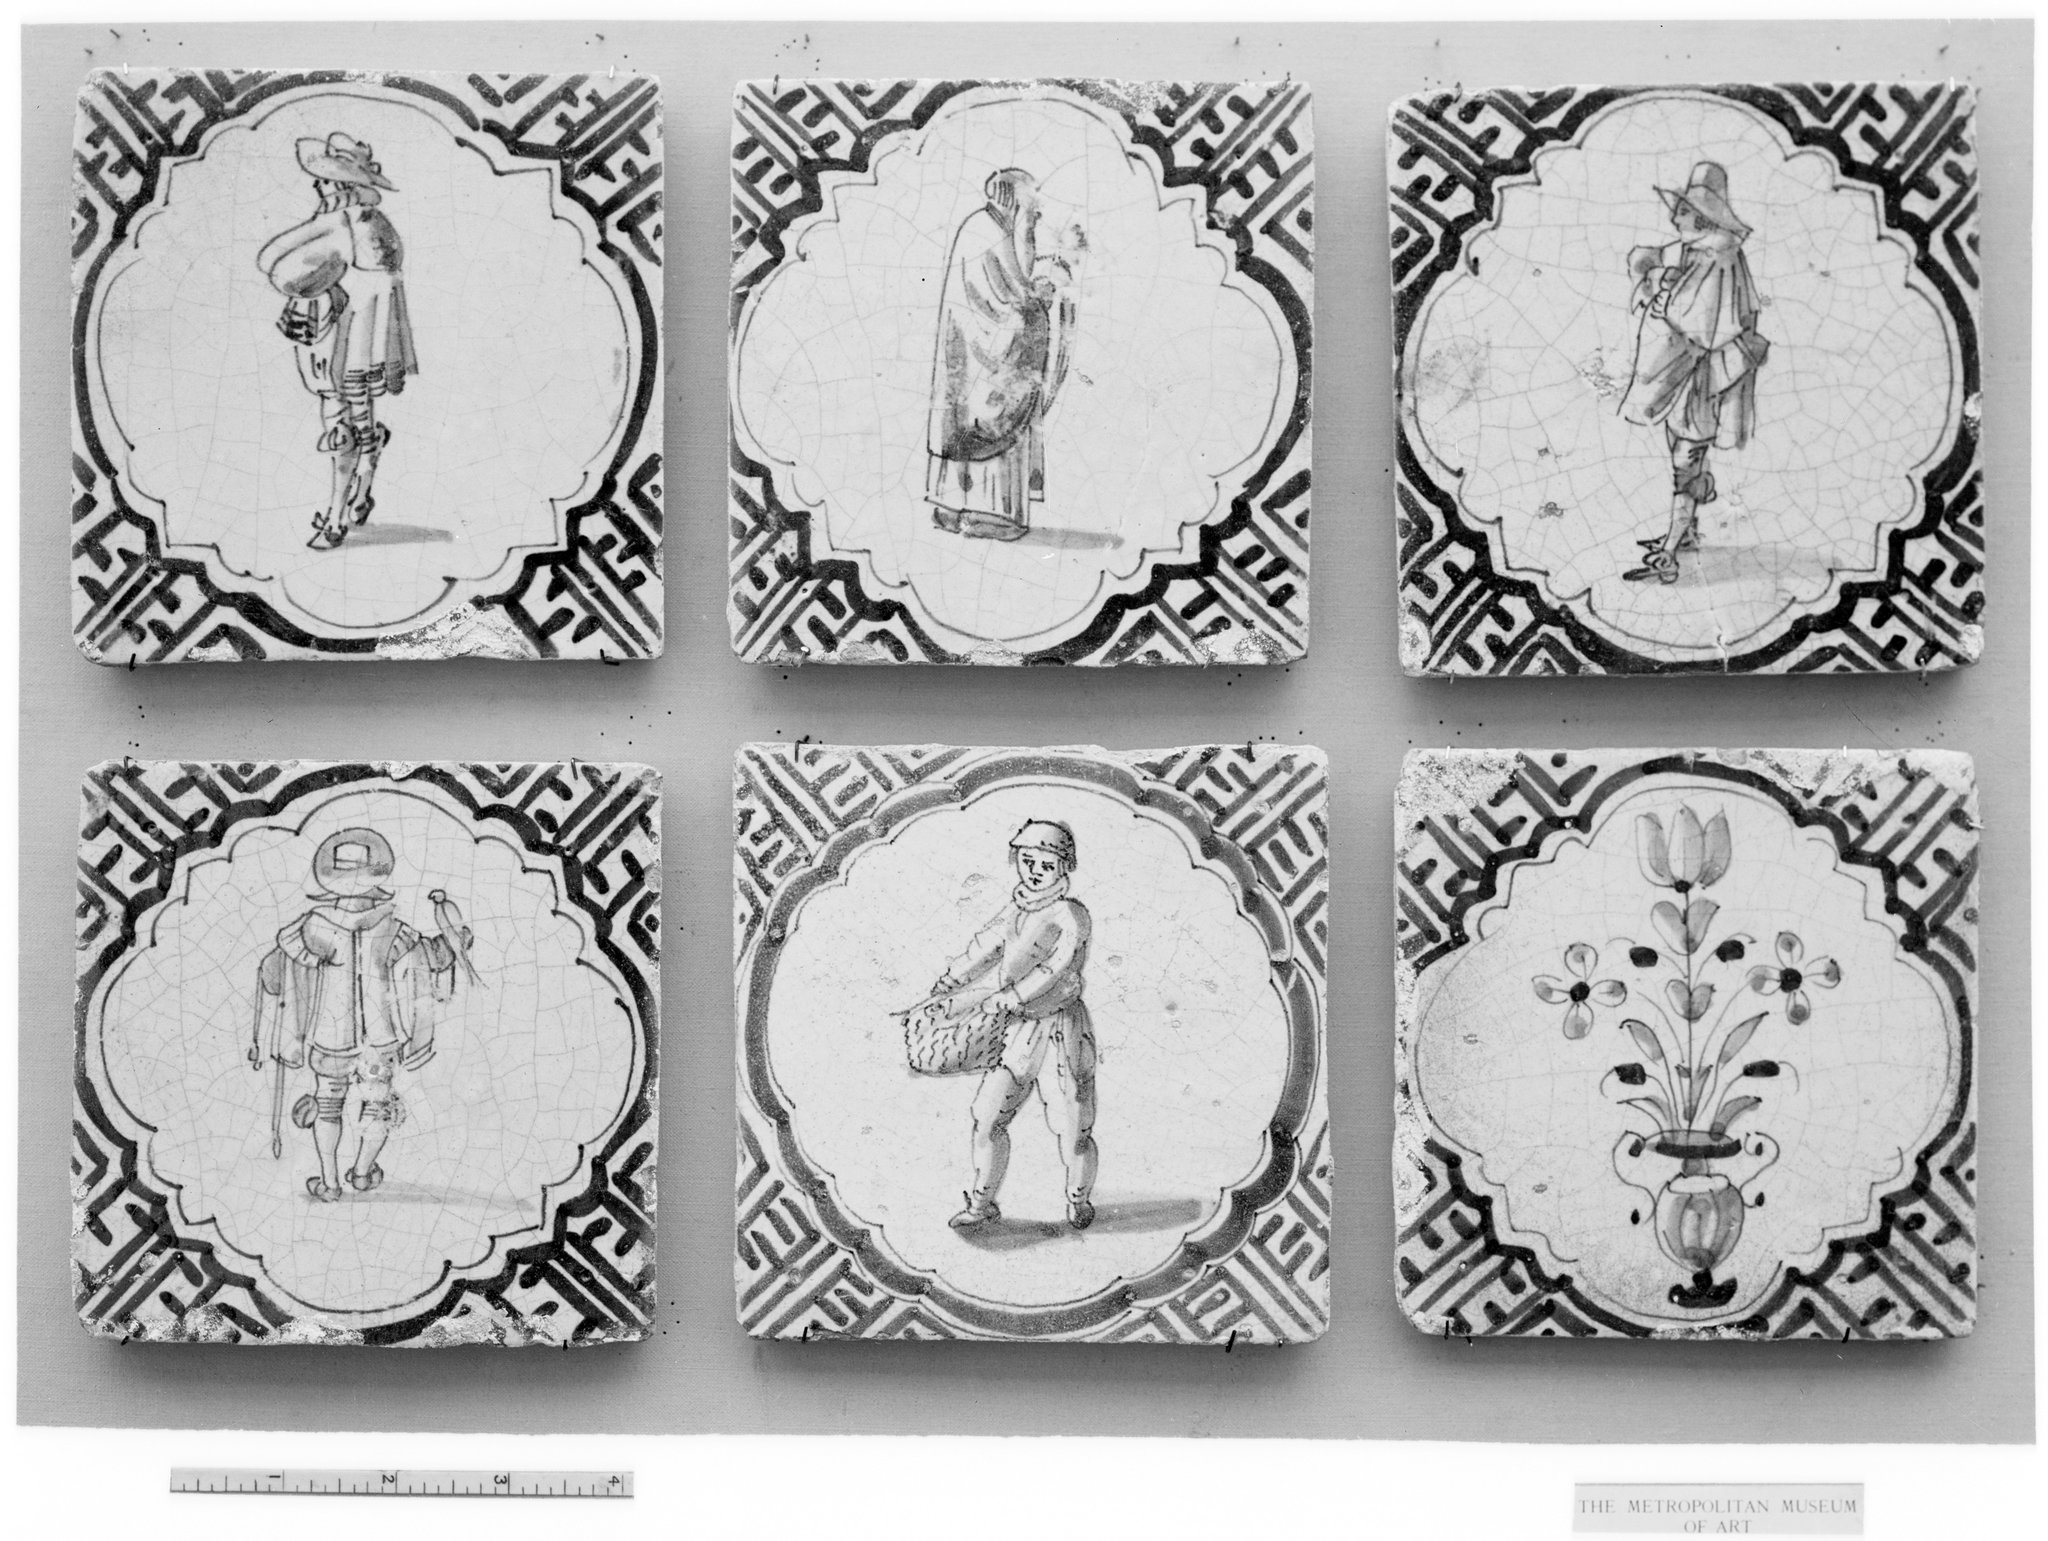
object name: tile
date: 1620-1640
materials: earthenware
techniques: glazing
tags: men,flowers